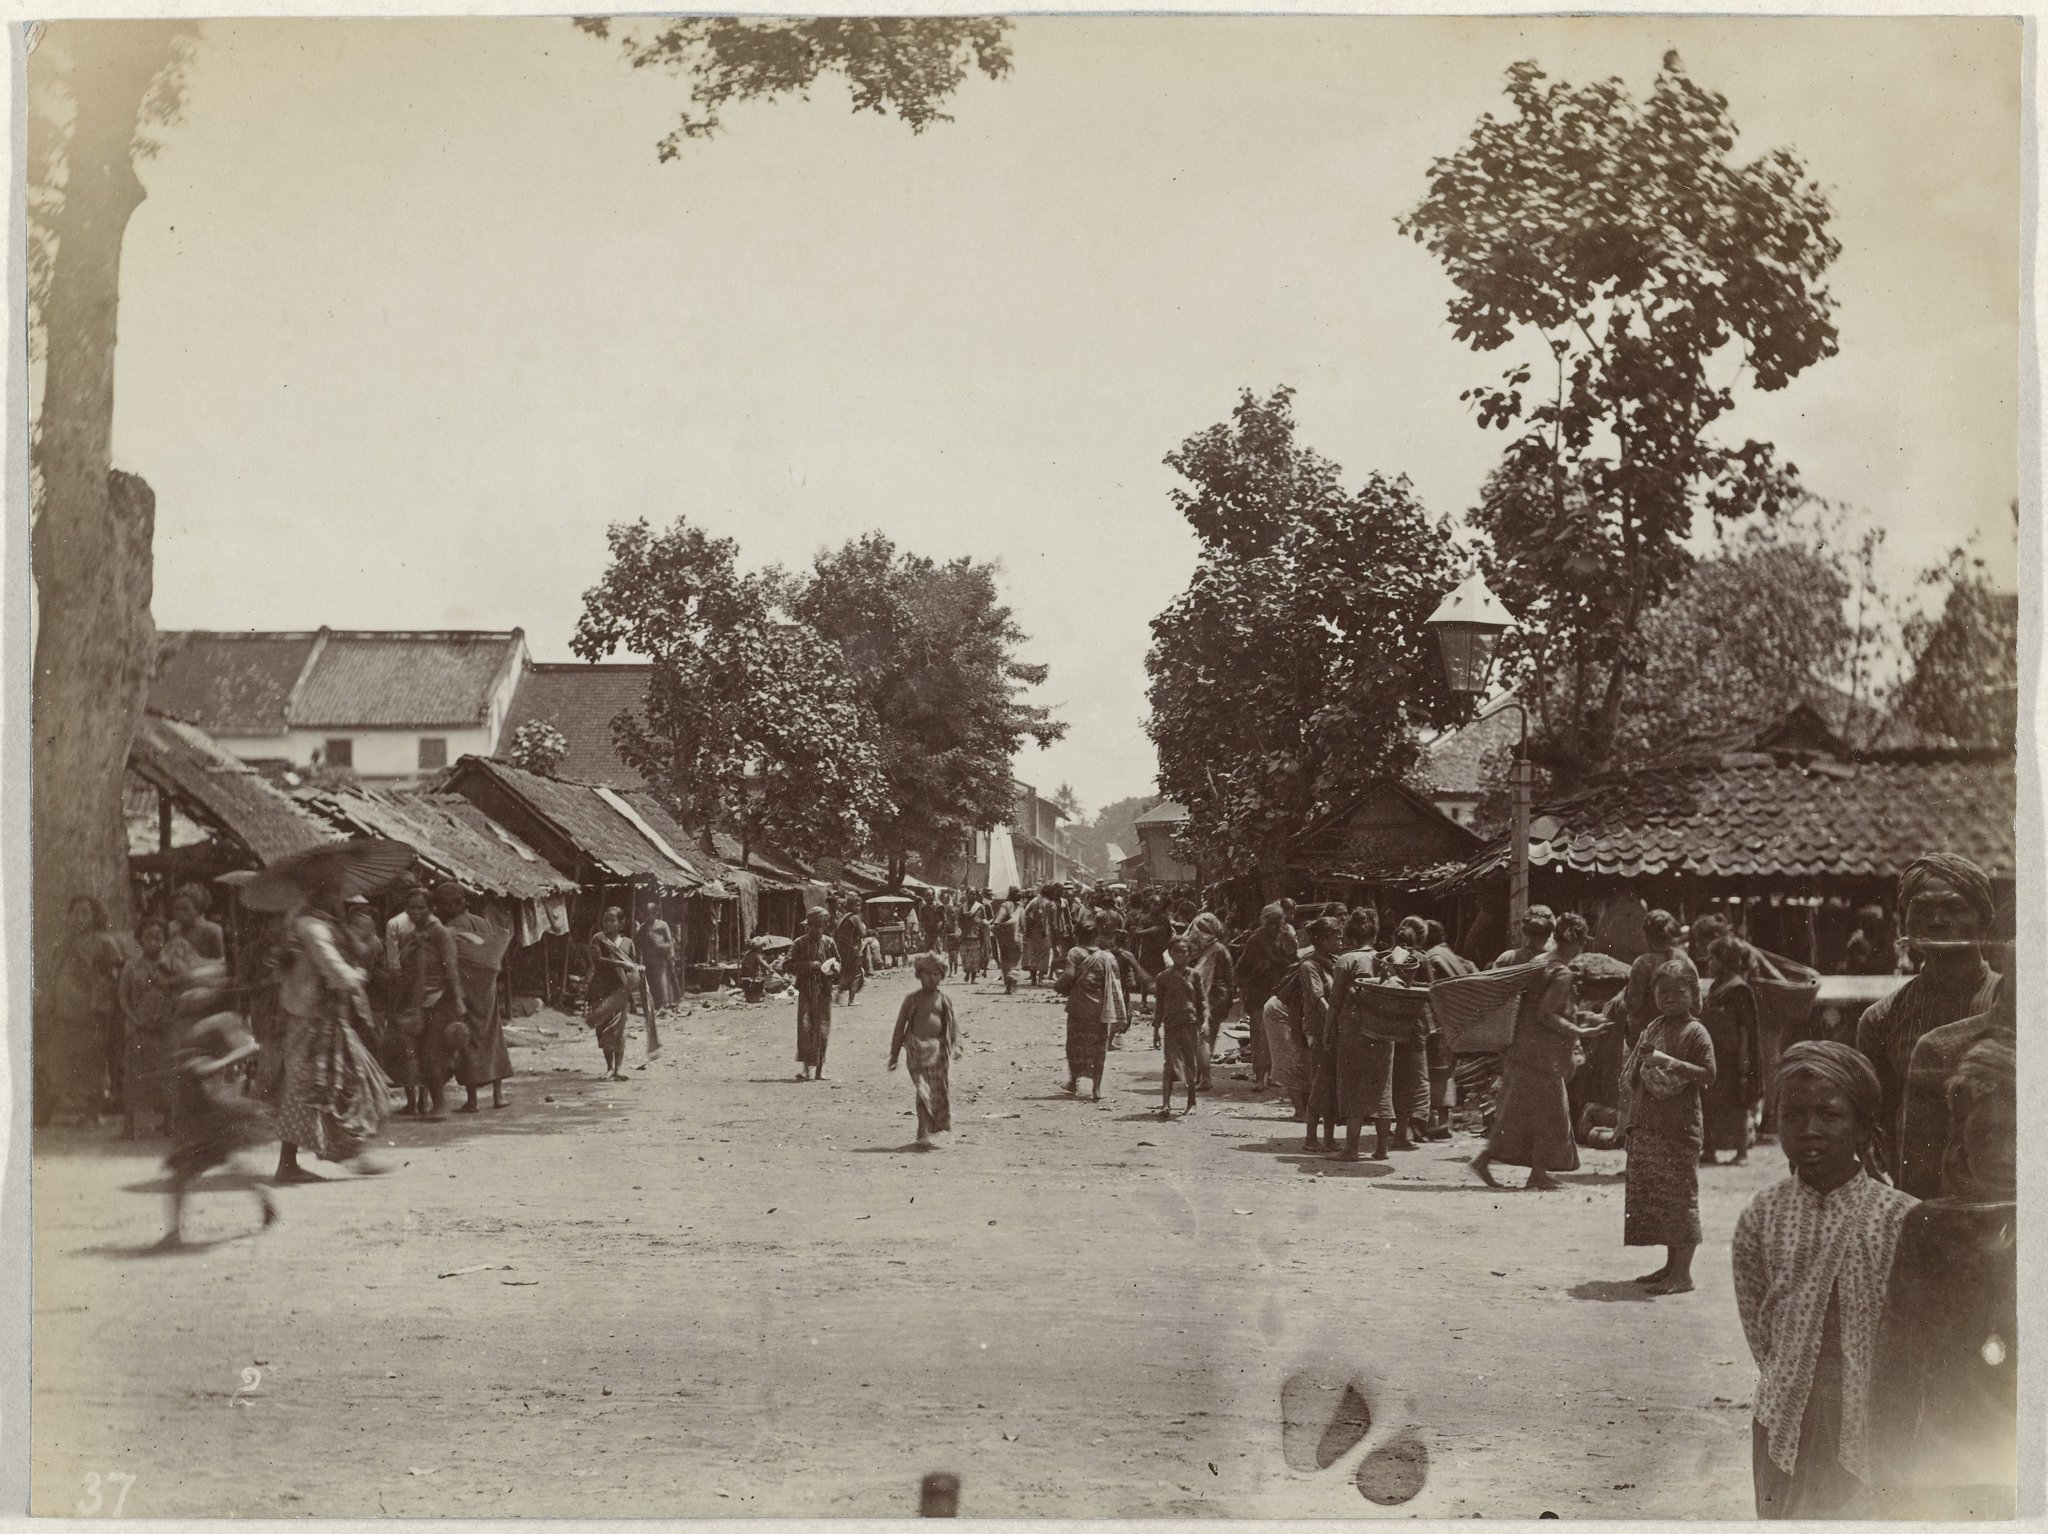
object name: photograph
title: Straatgezicht op de pasar in Jogjakarta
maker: kassian céphas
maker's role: fotograaf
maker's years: 1845-1912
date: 1890-1900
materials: paper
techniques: albumen print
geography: jogjakarta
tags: market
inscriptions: number: ‘37’, inscription: ‘Pasar (Java)’